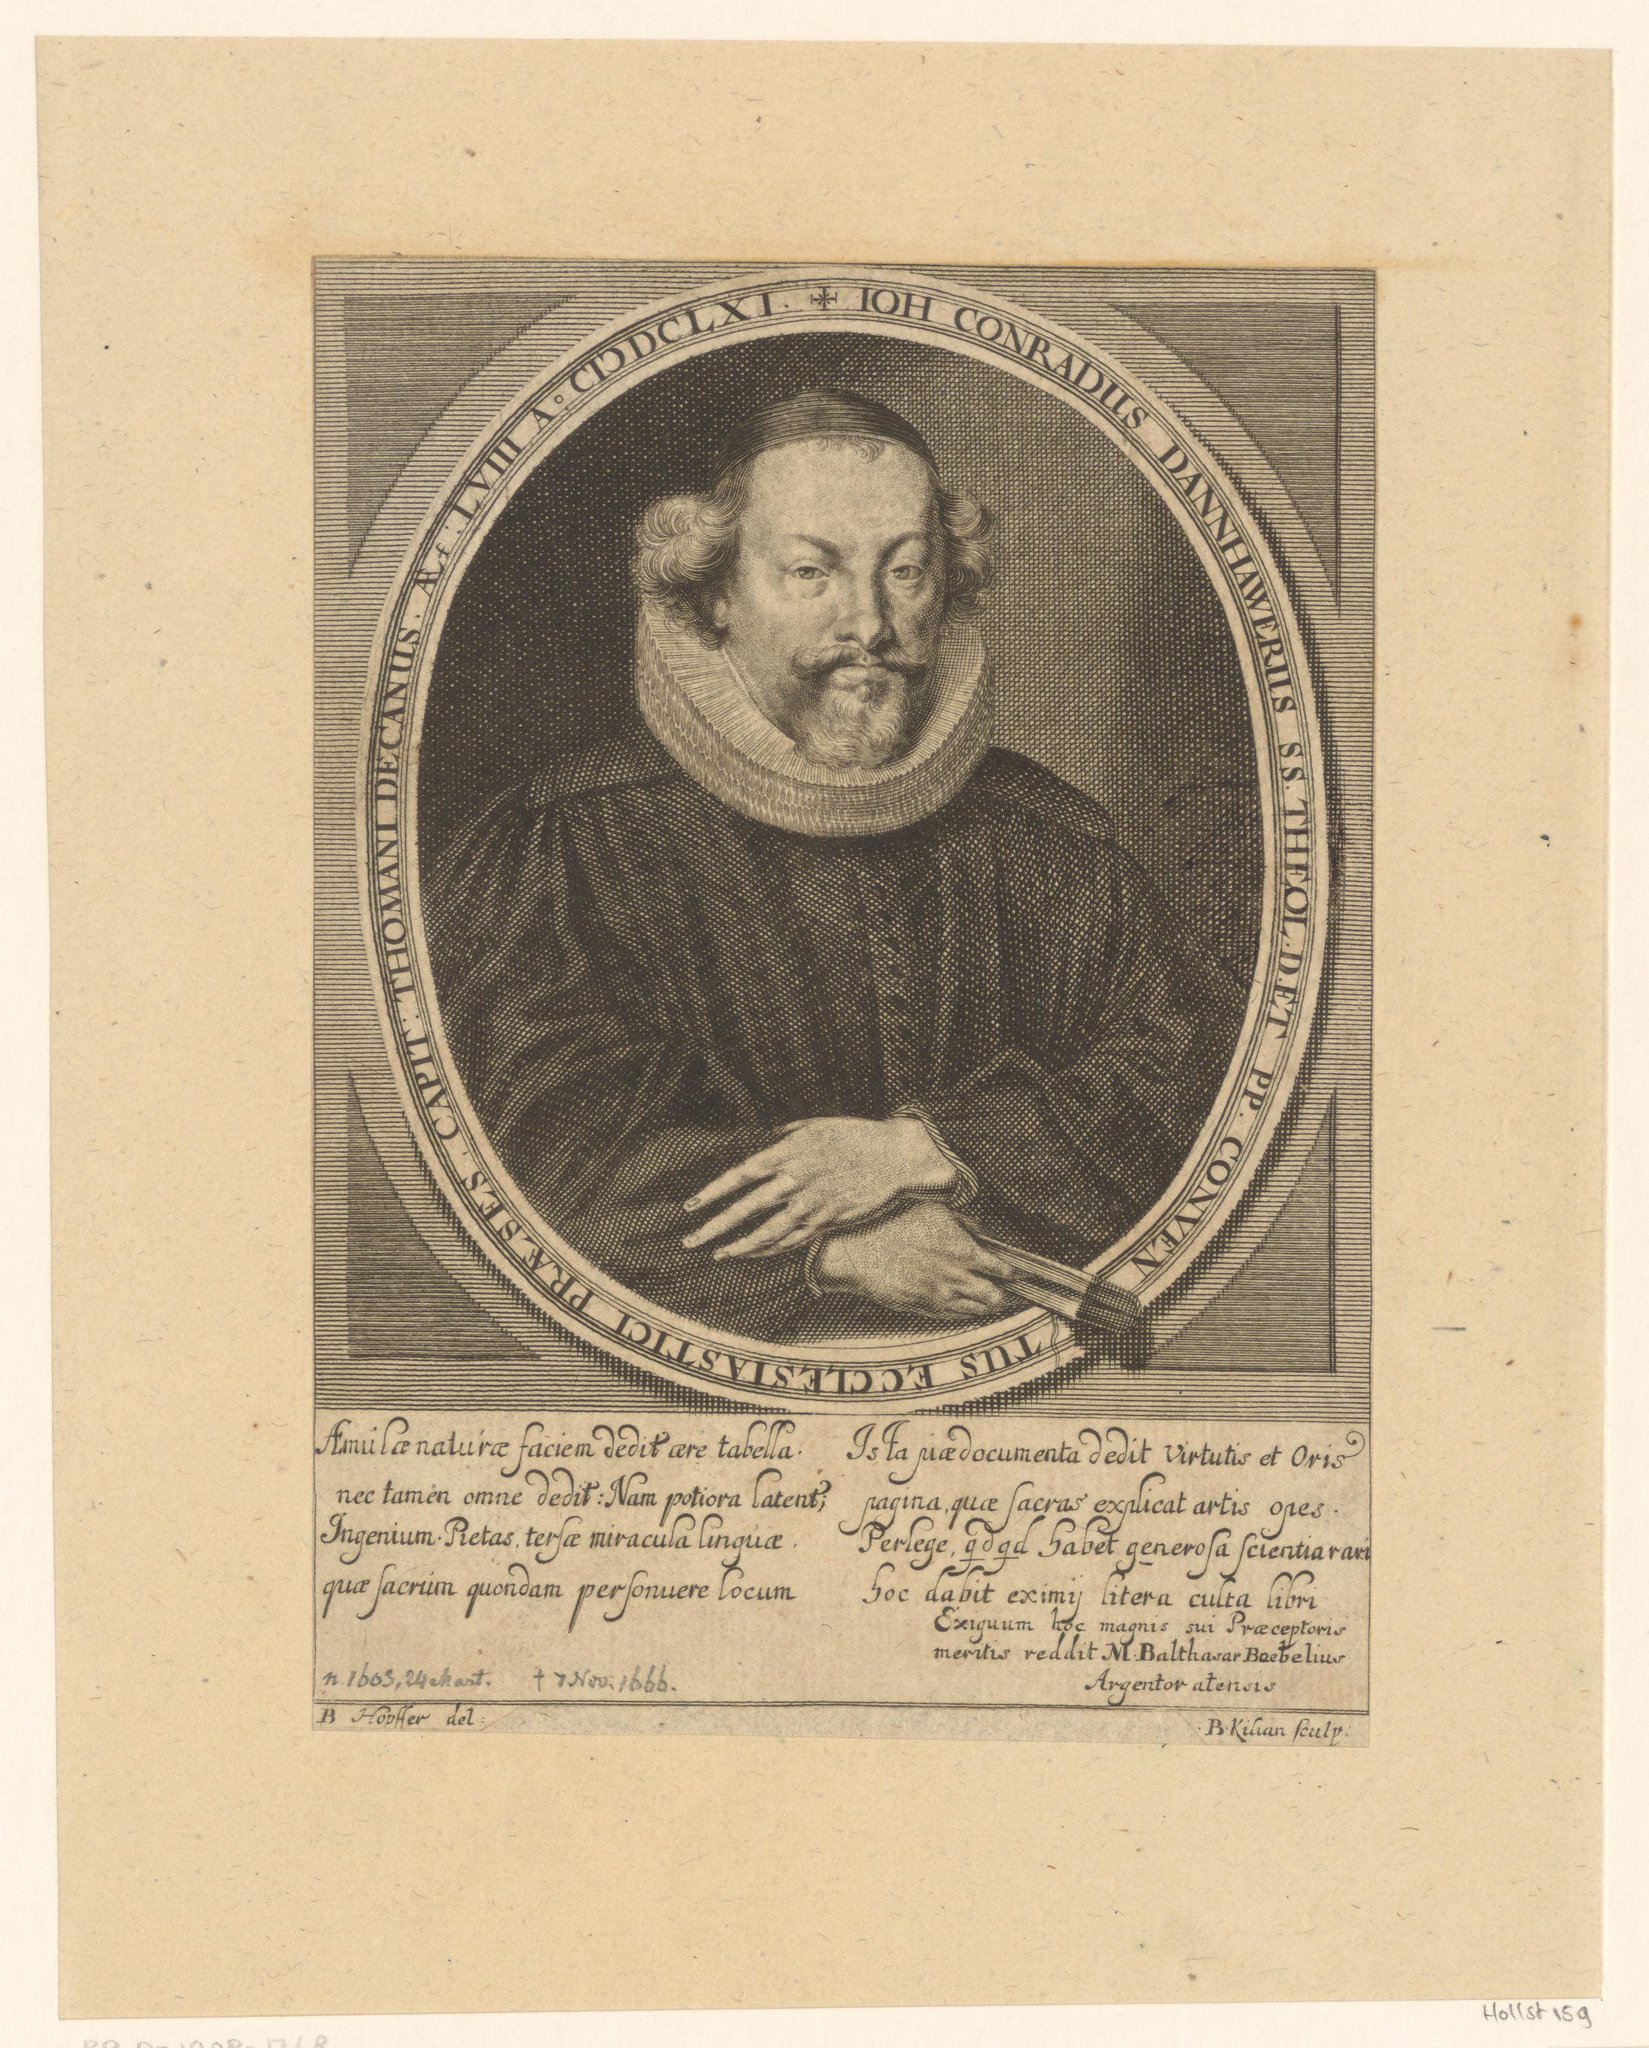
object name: print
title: Portret van Johann Conrad Dannhauer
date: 1661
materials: paper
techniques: engraving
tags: johann conrad dannhauer, theologian, historical persons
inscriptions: collector's mark: Lugt 2228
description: Tekst in het Latijn in de omlijsting van het medaillon en onderaan in de marge.